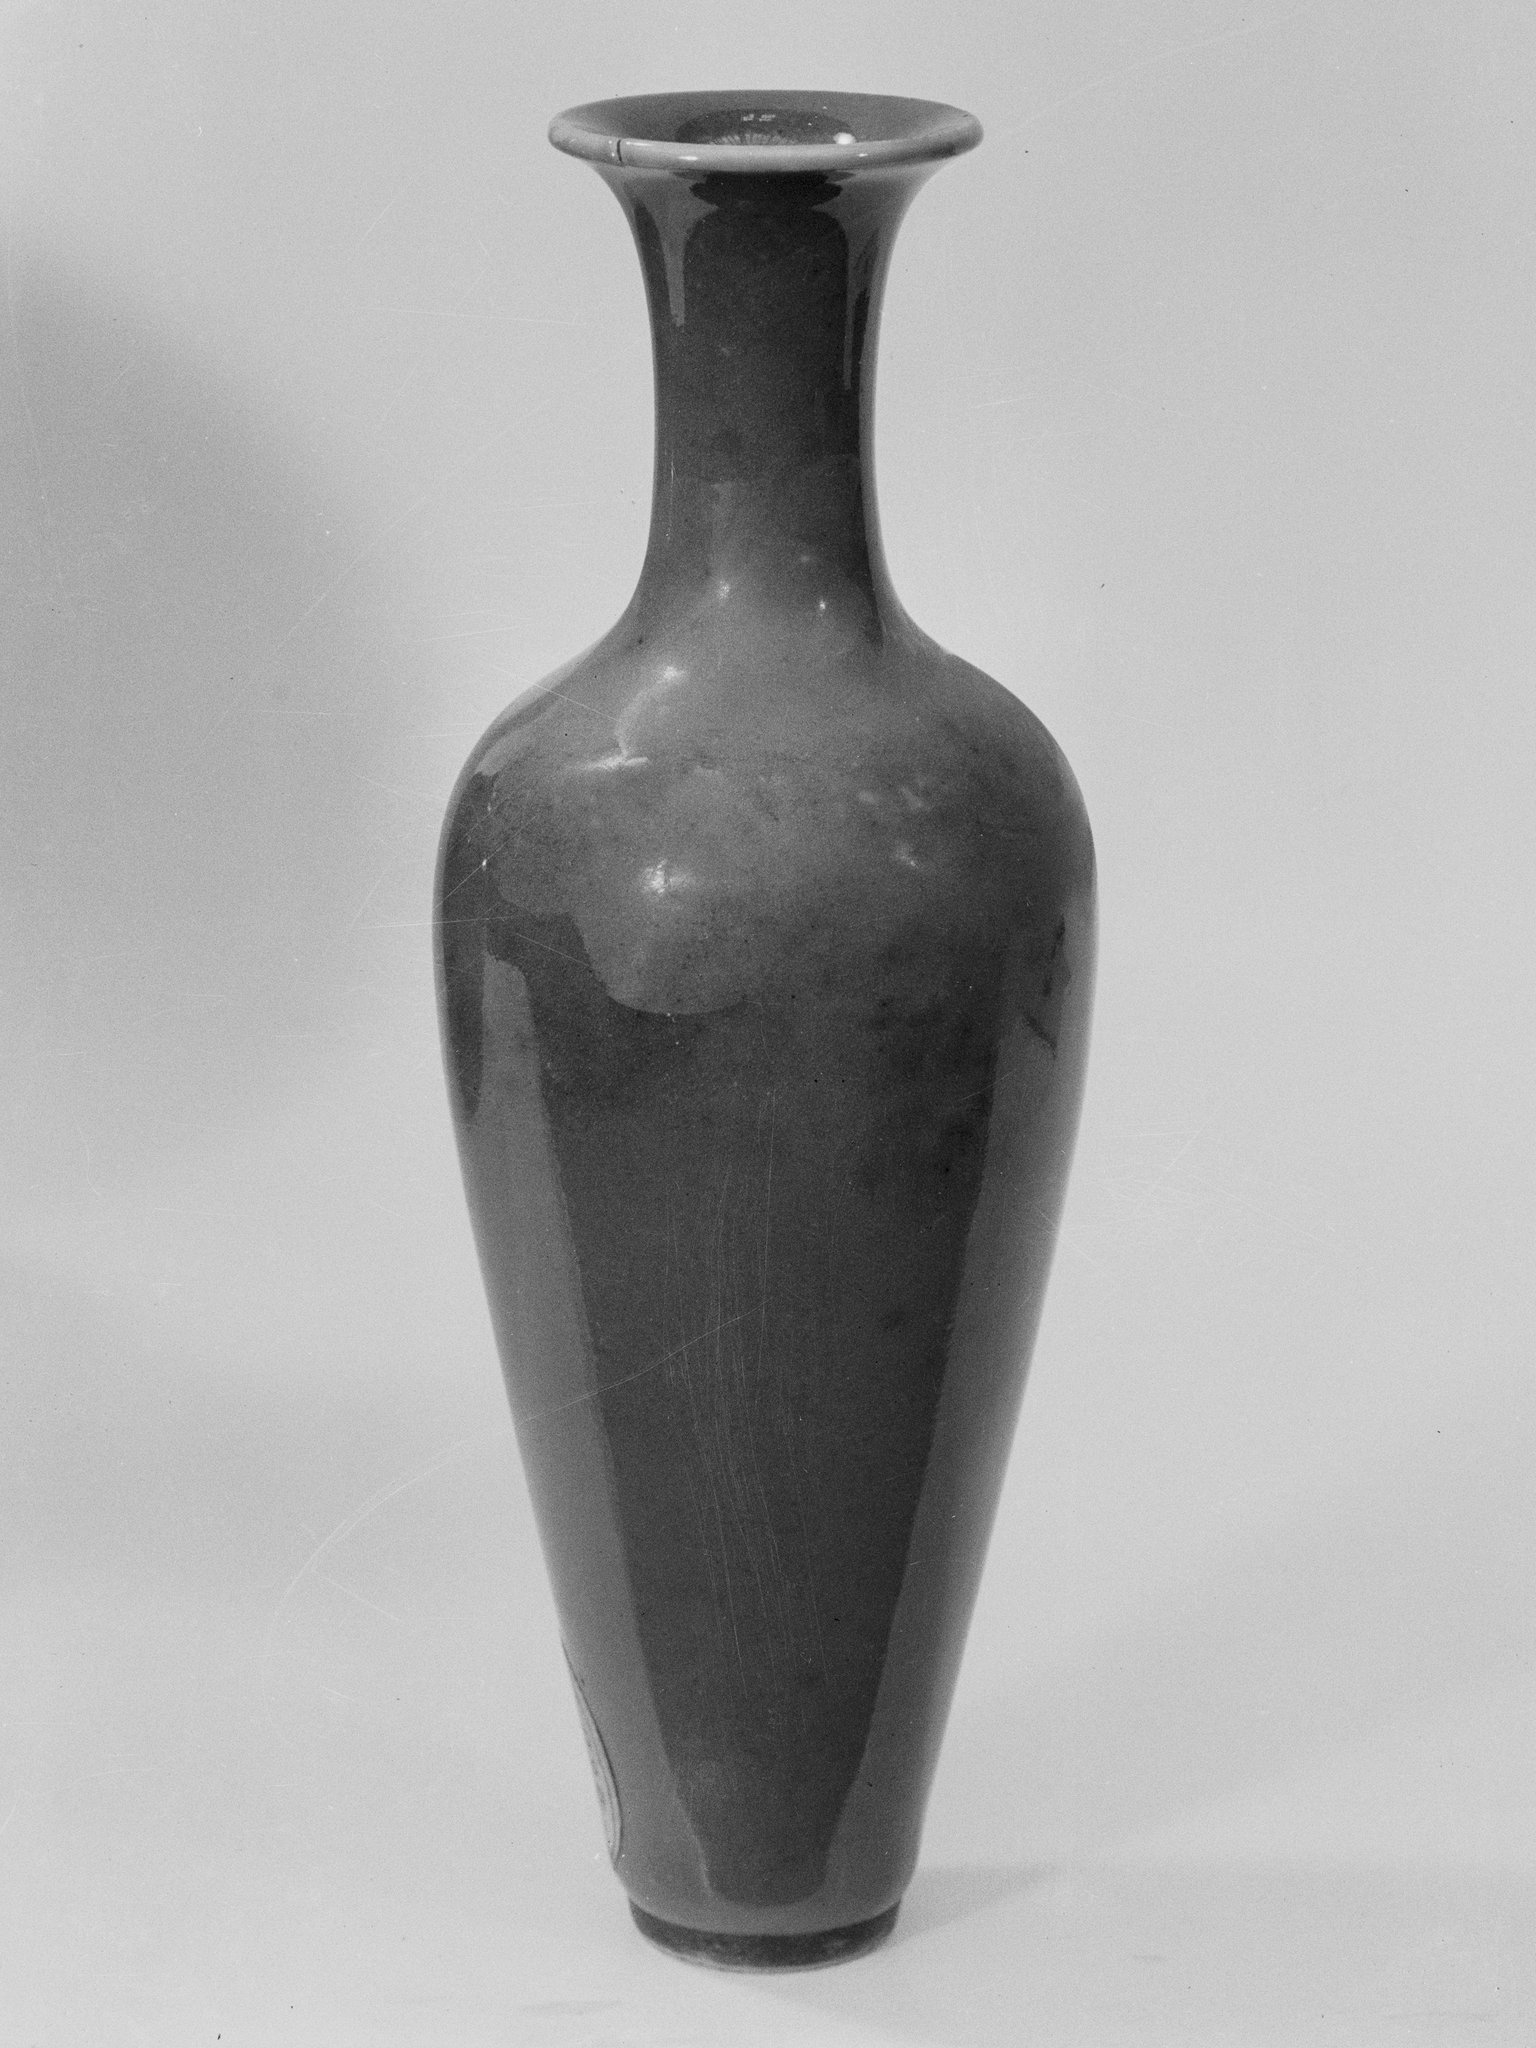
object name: vase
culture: chinese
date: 1662-1722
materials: glaze, porcelain